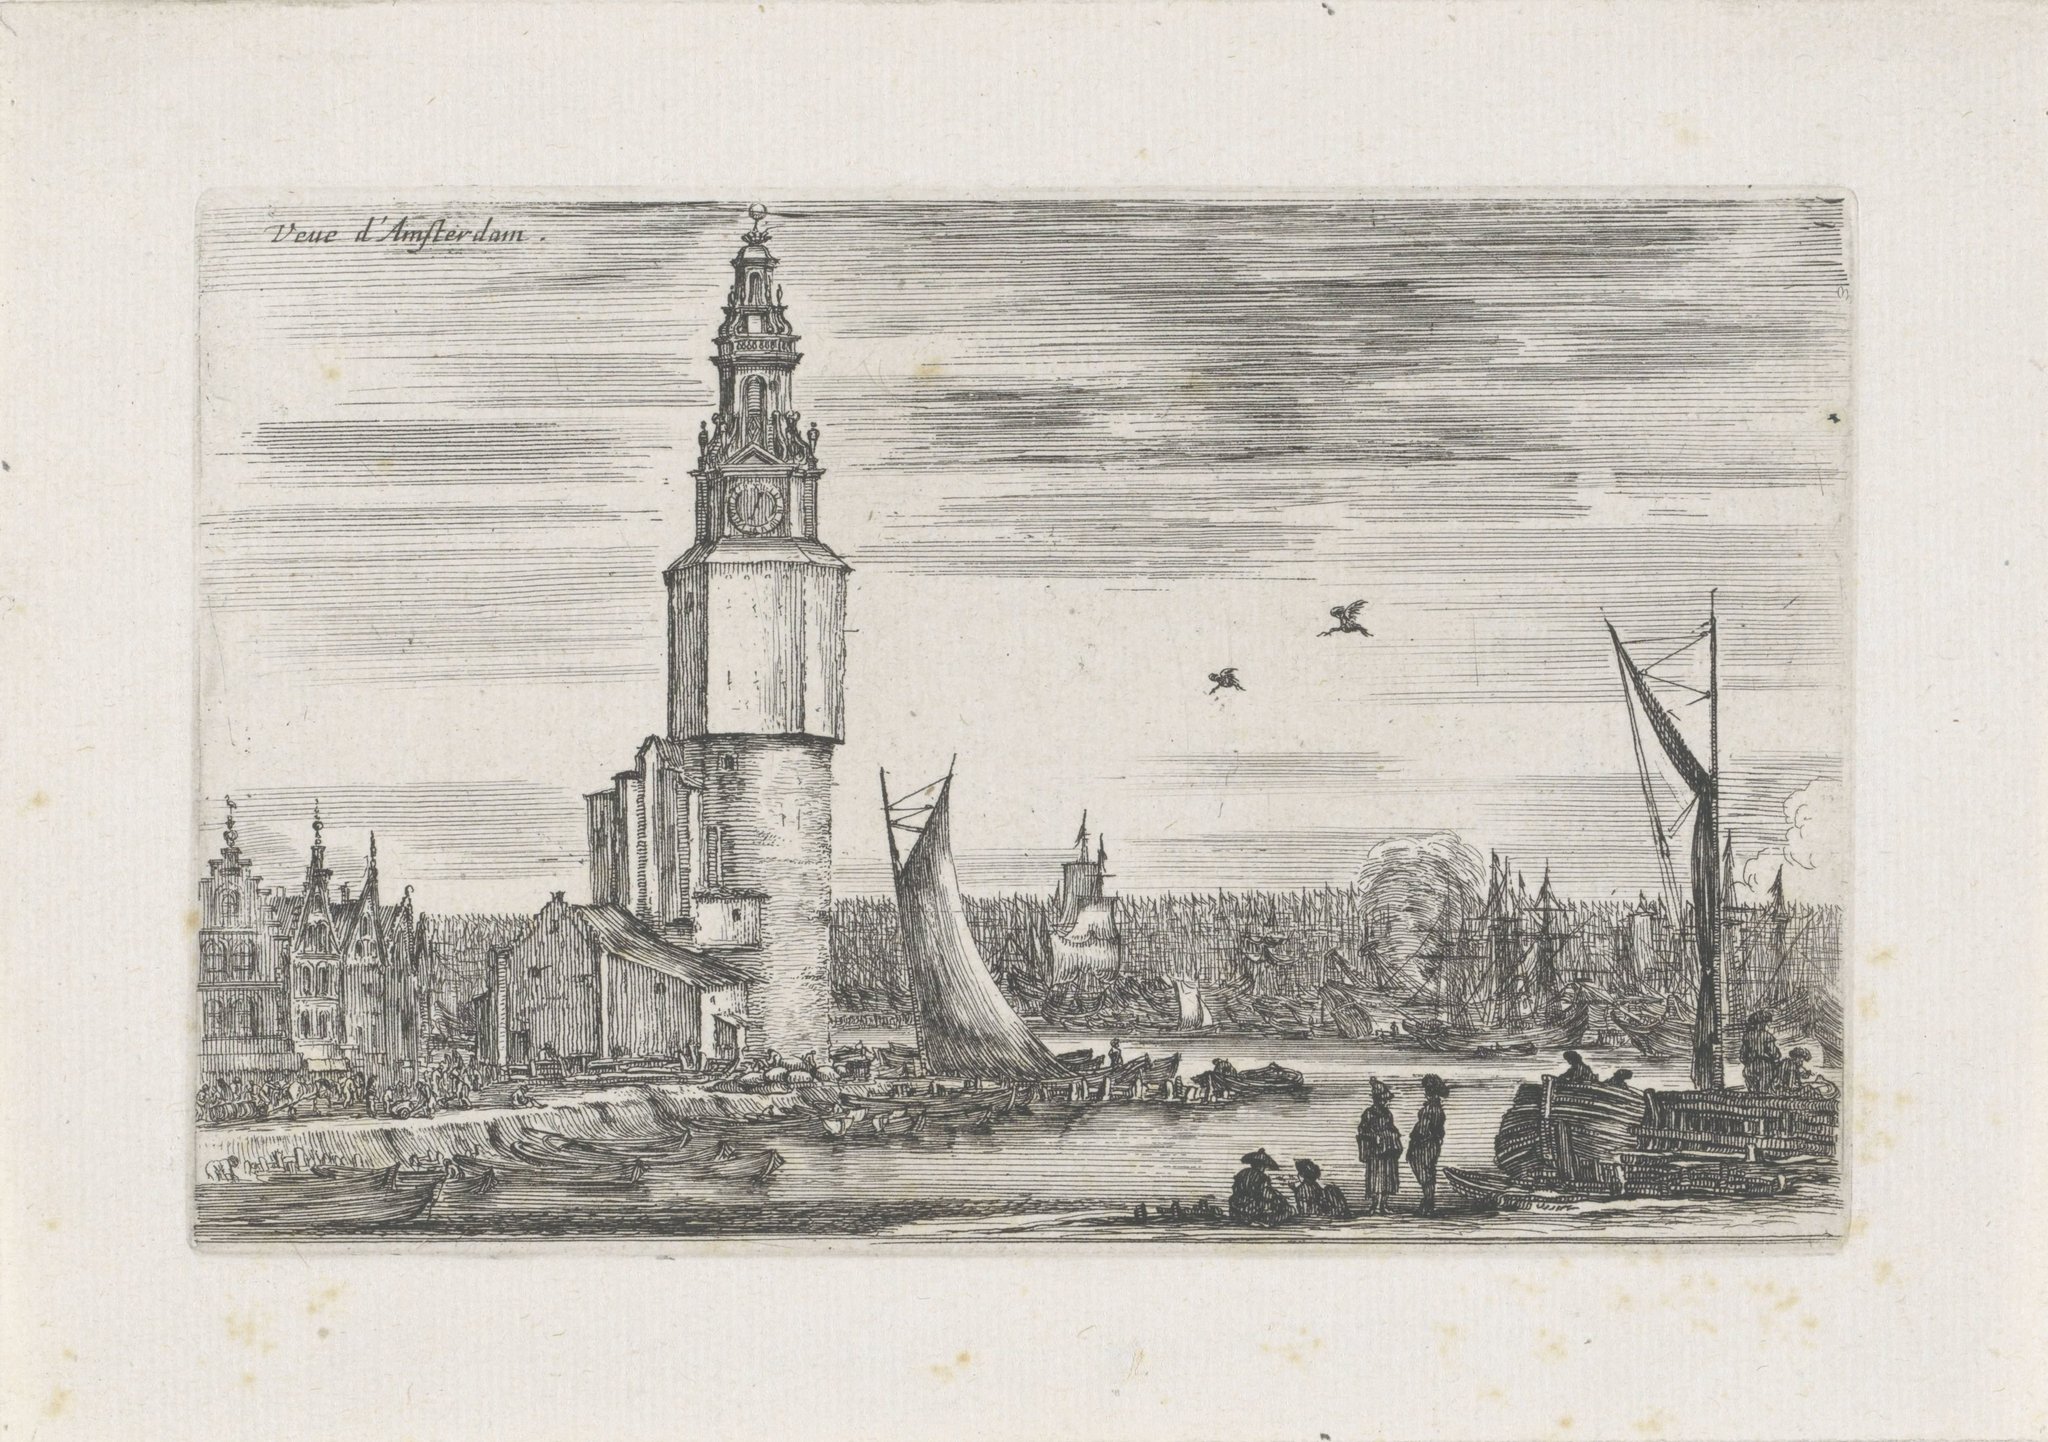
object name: print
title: Zeehavens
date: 1647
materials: paper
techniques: etching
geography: paris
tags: city-view, and landscape with man-made constructions, tower, clock tower ~ monumental adornment, ships (in general)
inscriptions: collector's mark: Lugt 240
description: Gezicht op Amsterdam met schepen bij de Haringpakkerstoren.